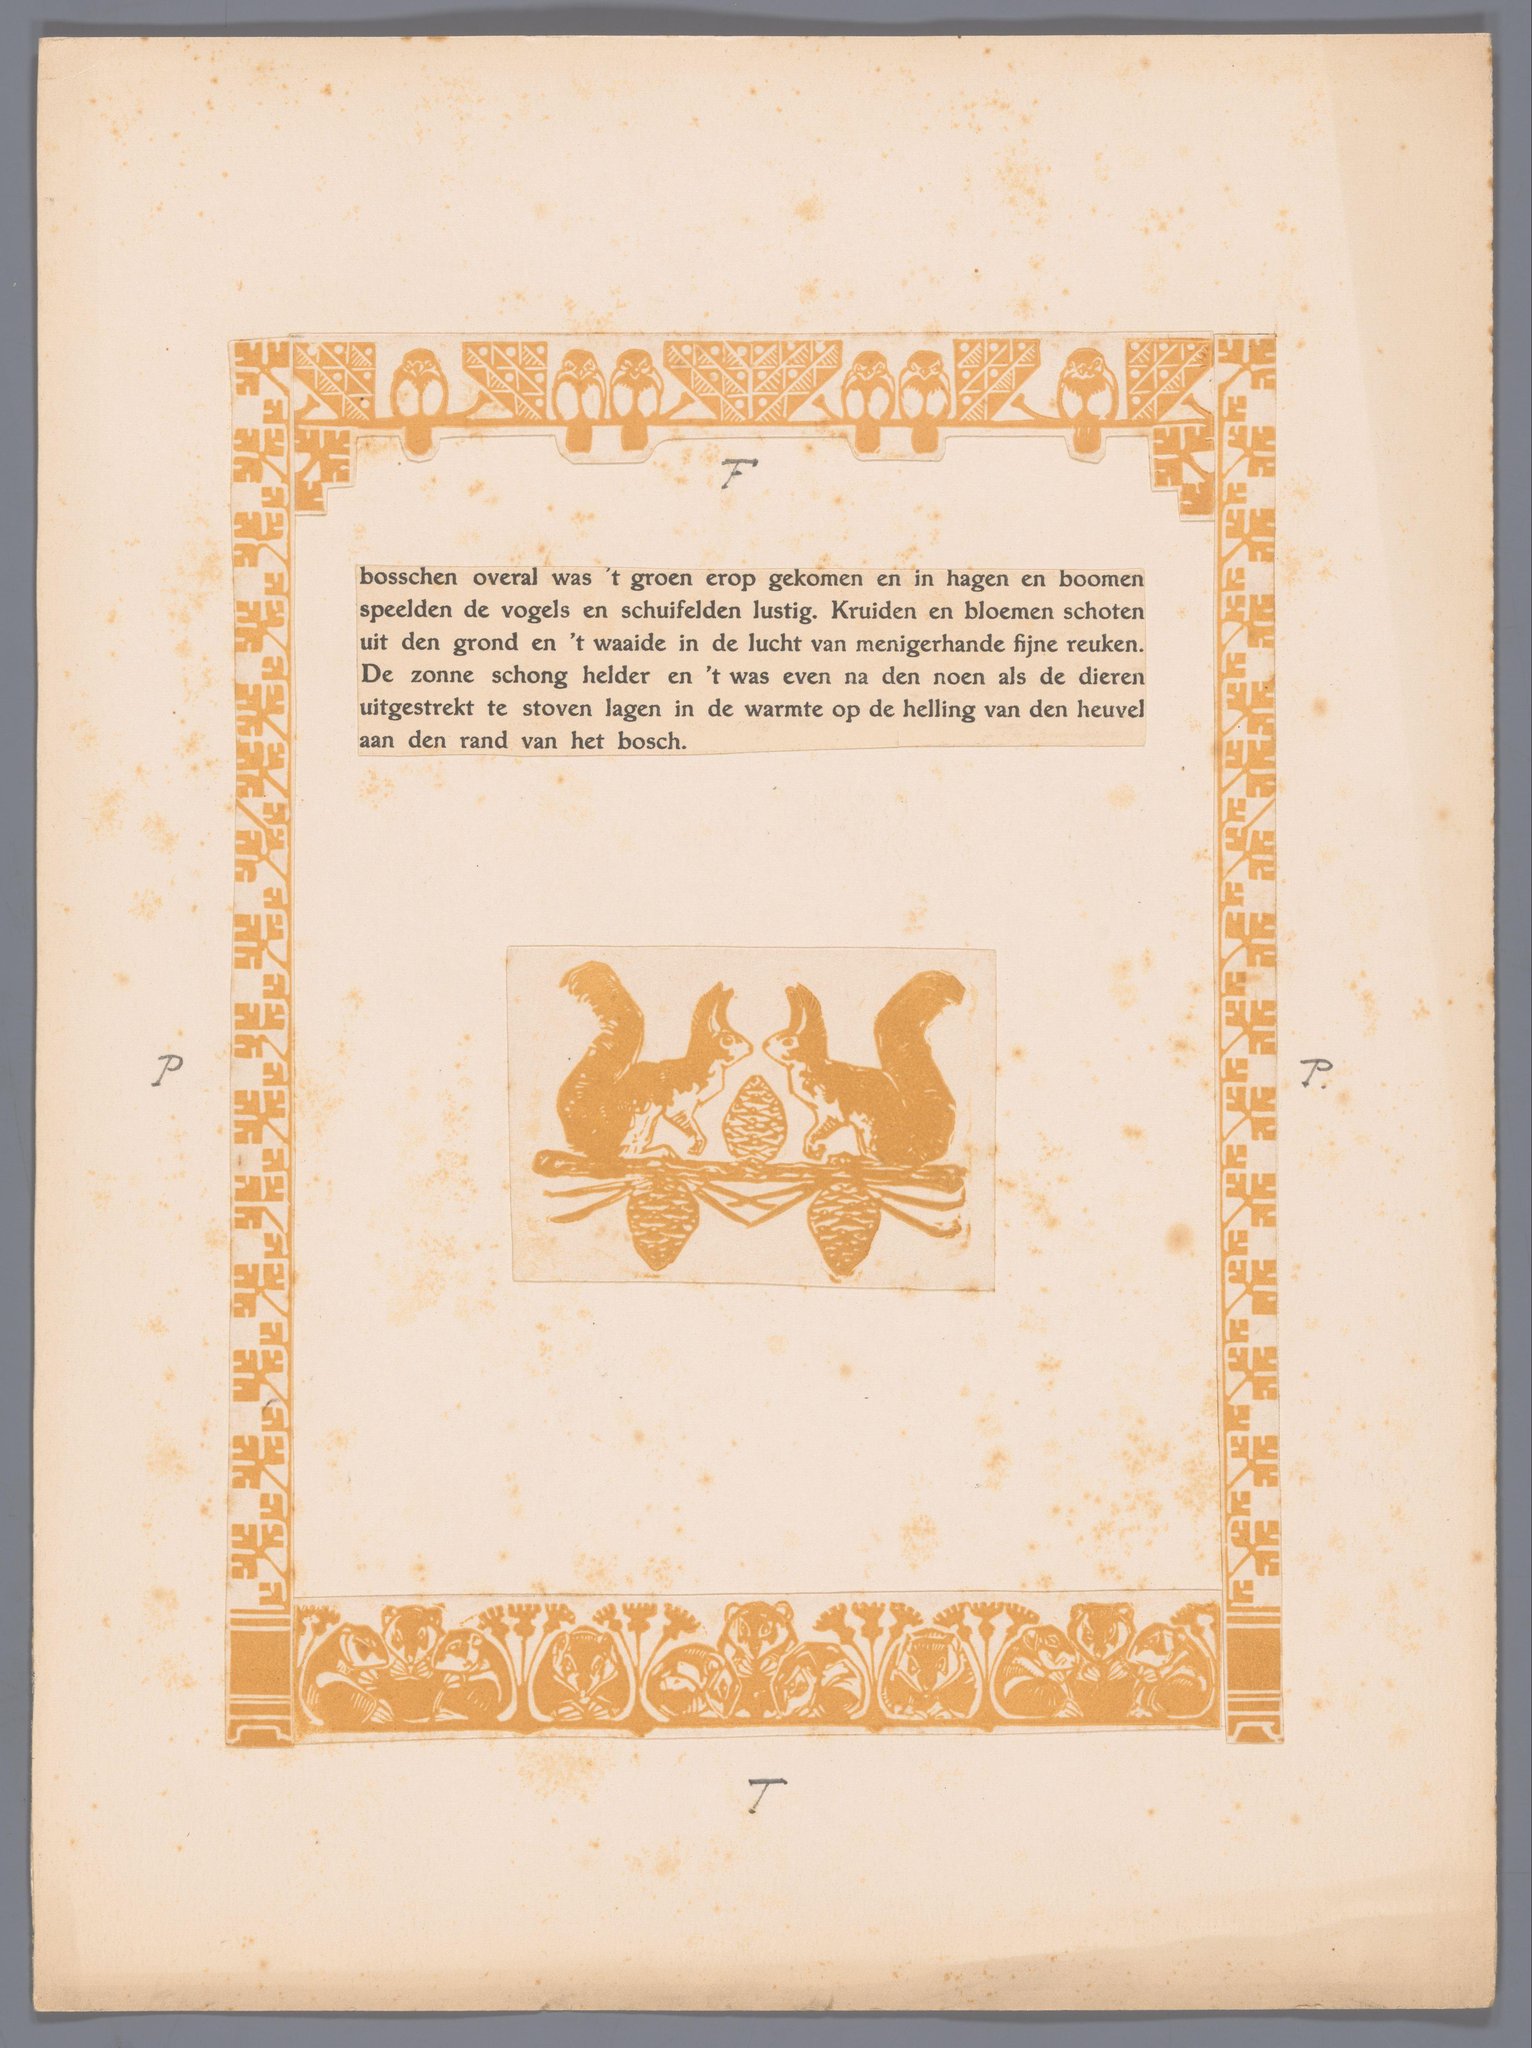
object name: boekillustratie ontwerp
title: Proefdruk voor pagina uit Reinaert de Vos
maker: bernard willem wierink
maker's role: draughtsman, print maker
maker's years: 1856-1939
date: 1910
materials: paper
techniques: letterpress printing, relief print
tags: fable of reynard the fox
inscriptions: collector's mark: Lugt 2228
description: Ontwerp voor: Streuvels, Stijn (Frank Lateur). Reinaert de Vos naar verschillende uitgaven van het middeleeuwsche epos. Amsterdam: L.J. Veen, 1910. Deze prent is vermoedelijk een plaatsnede, ook al wordt in de literatuur veelal gesproken over een houtsnede. Voor zover Wierink zijn prenten in hoogdruk zelf nader heeft omschreven, heeft hij altijd de term 'plaatsnede' gebruikt.